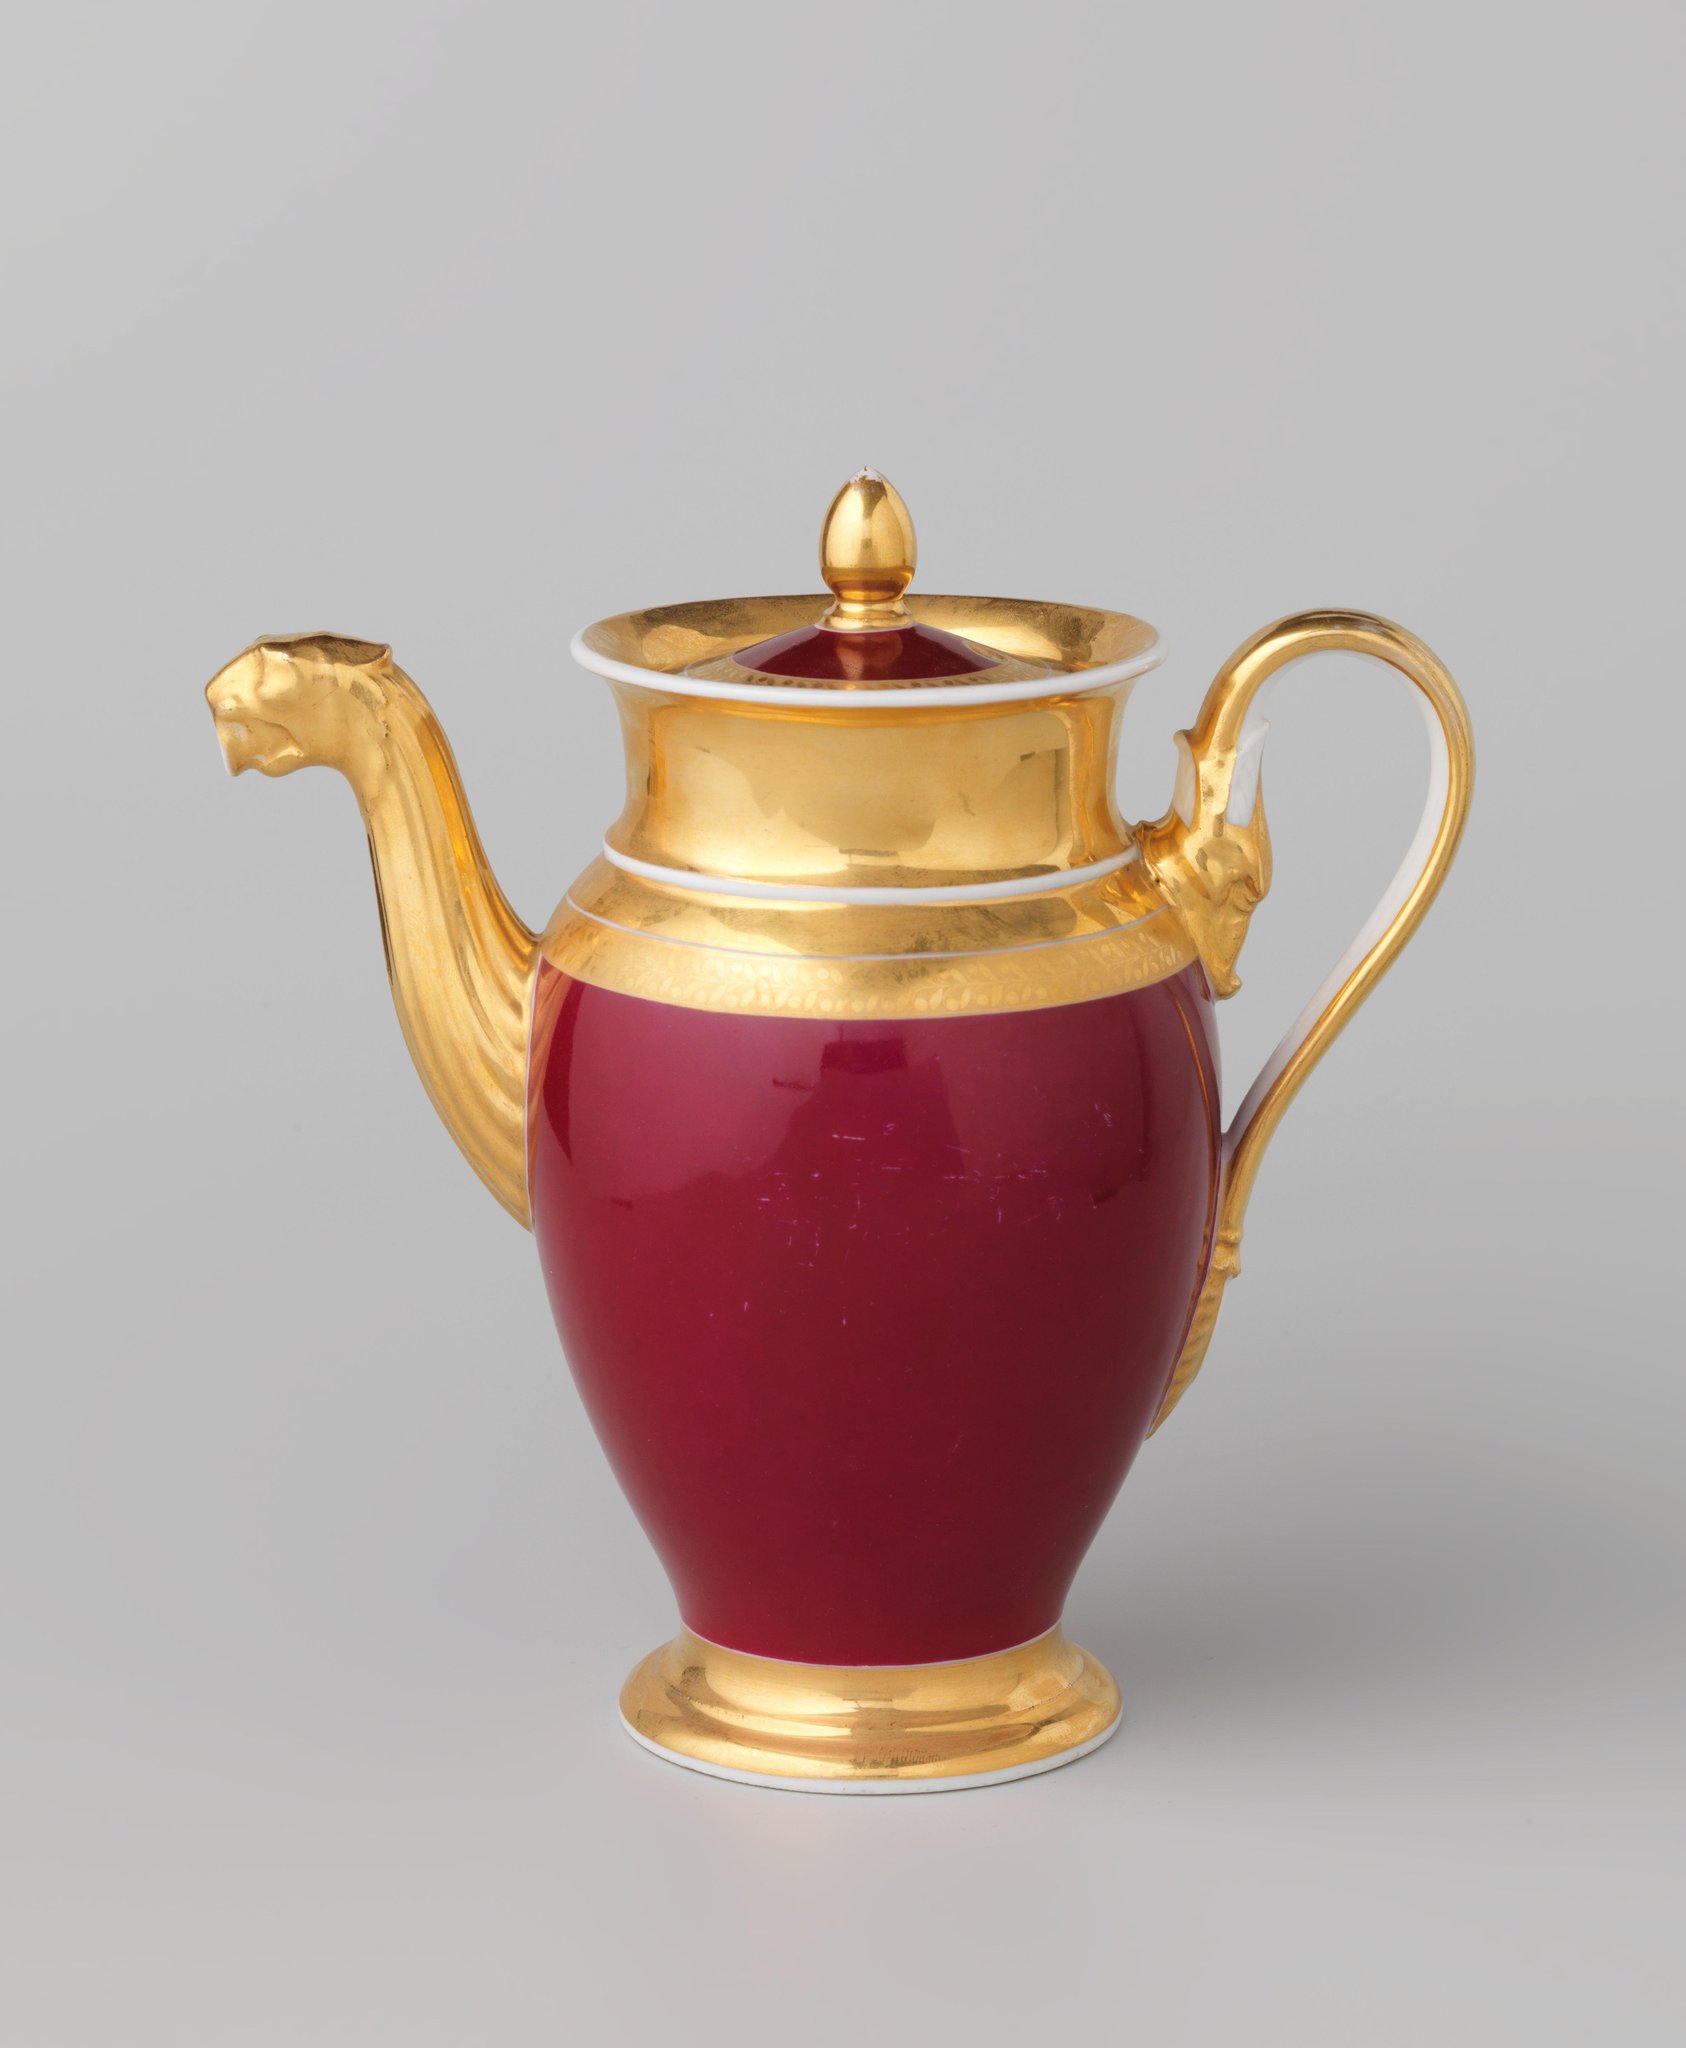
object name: service set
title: Coffeepot with gold borders on a red ground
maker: Anonymous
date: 1800-1824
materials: glaze, gold, paint, porcelain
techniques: firing, forming, gilding, turning, vitrification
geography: france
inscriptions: mark: ‘e[?]/ X’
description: Koffiekan van porselein, bedekt op het glazuur met rood en goud. De kan heeft een eivormig lichaam op een spreidende voet en een wijde, spreidende nek. De S-vormige tuit is gemodelleerd in de vorm van een vogelkop en het hoge oor heeft bij de basis een schelpmotief en een palmet. De buik is bedekt met rood en de voet, schouder, nek, tuit en het oor met goud. Op de schouder een bloemrank in één van de gouden banden. De deksel met dezelfde decoratie. Gemerkt op de onderzijde met e[?] en X. Empire.